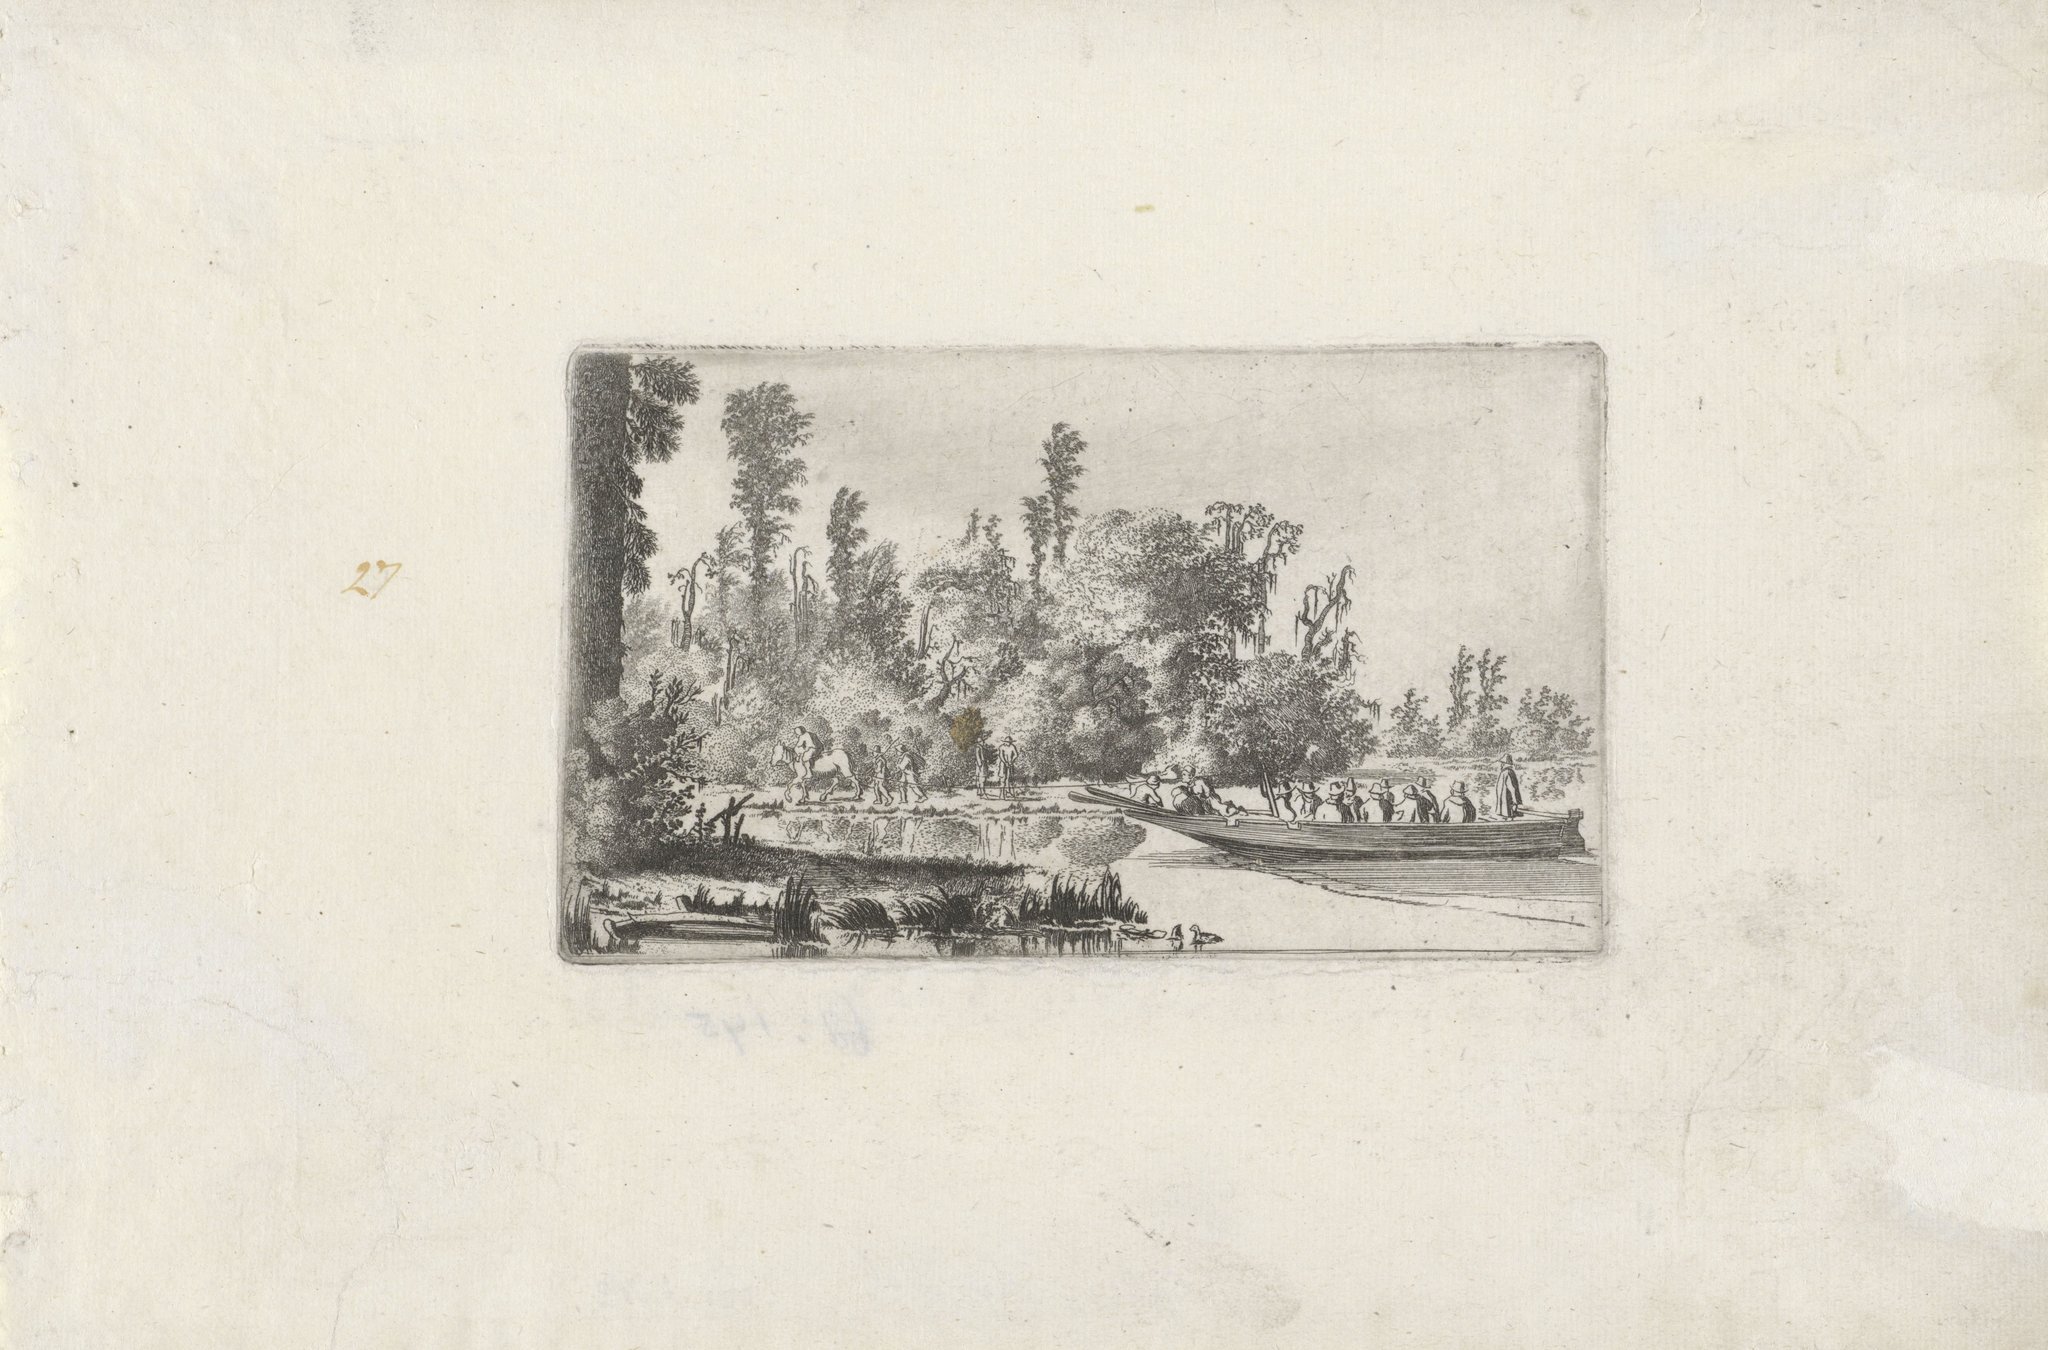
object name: print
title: Zes landschappen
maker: gillis van scheyndel (i)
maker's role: draughtsman, print maker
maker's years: 1595-1660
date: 1605-1653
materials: paper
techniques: etching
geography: netherlands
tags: river, rowing-boat, canoe, etc., forest, wood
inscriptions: collector's mark: Lugt 2760, collector's mark: Lugt 2228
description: Gezicht op een rivier met een boot met figuren. Aan de waterkant, aan de rand van het bos, bevinden zich een ruiter en vier mannen. De prent maakt deel uit van een serie van zes landschappen.